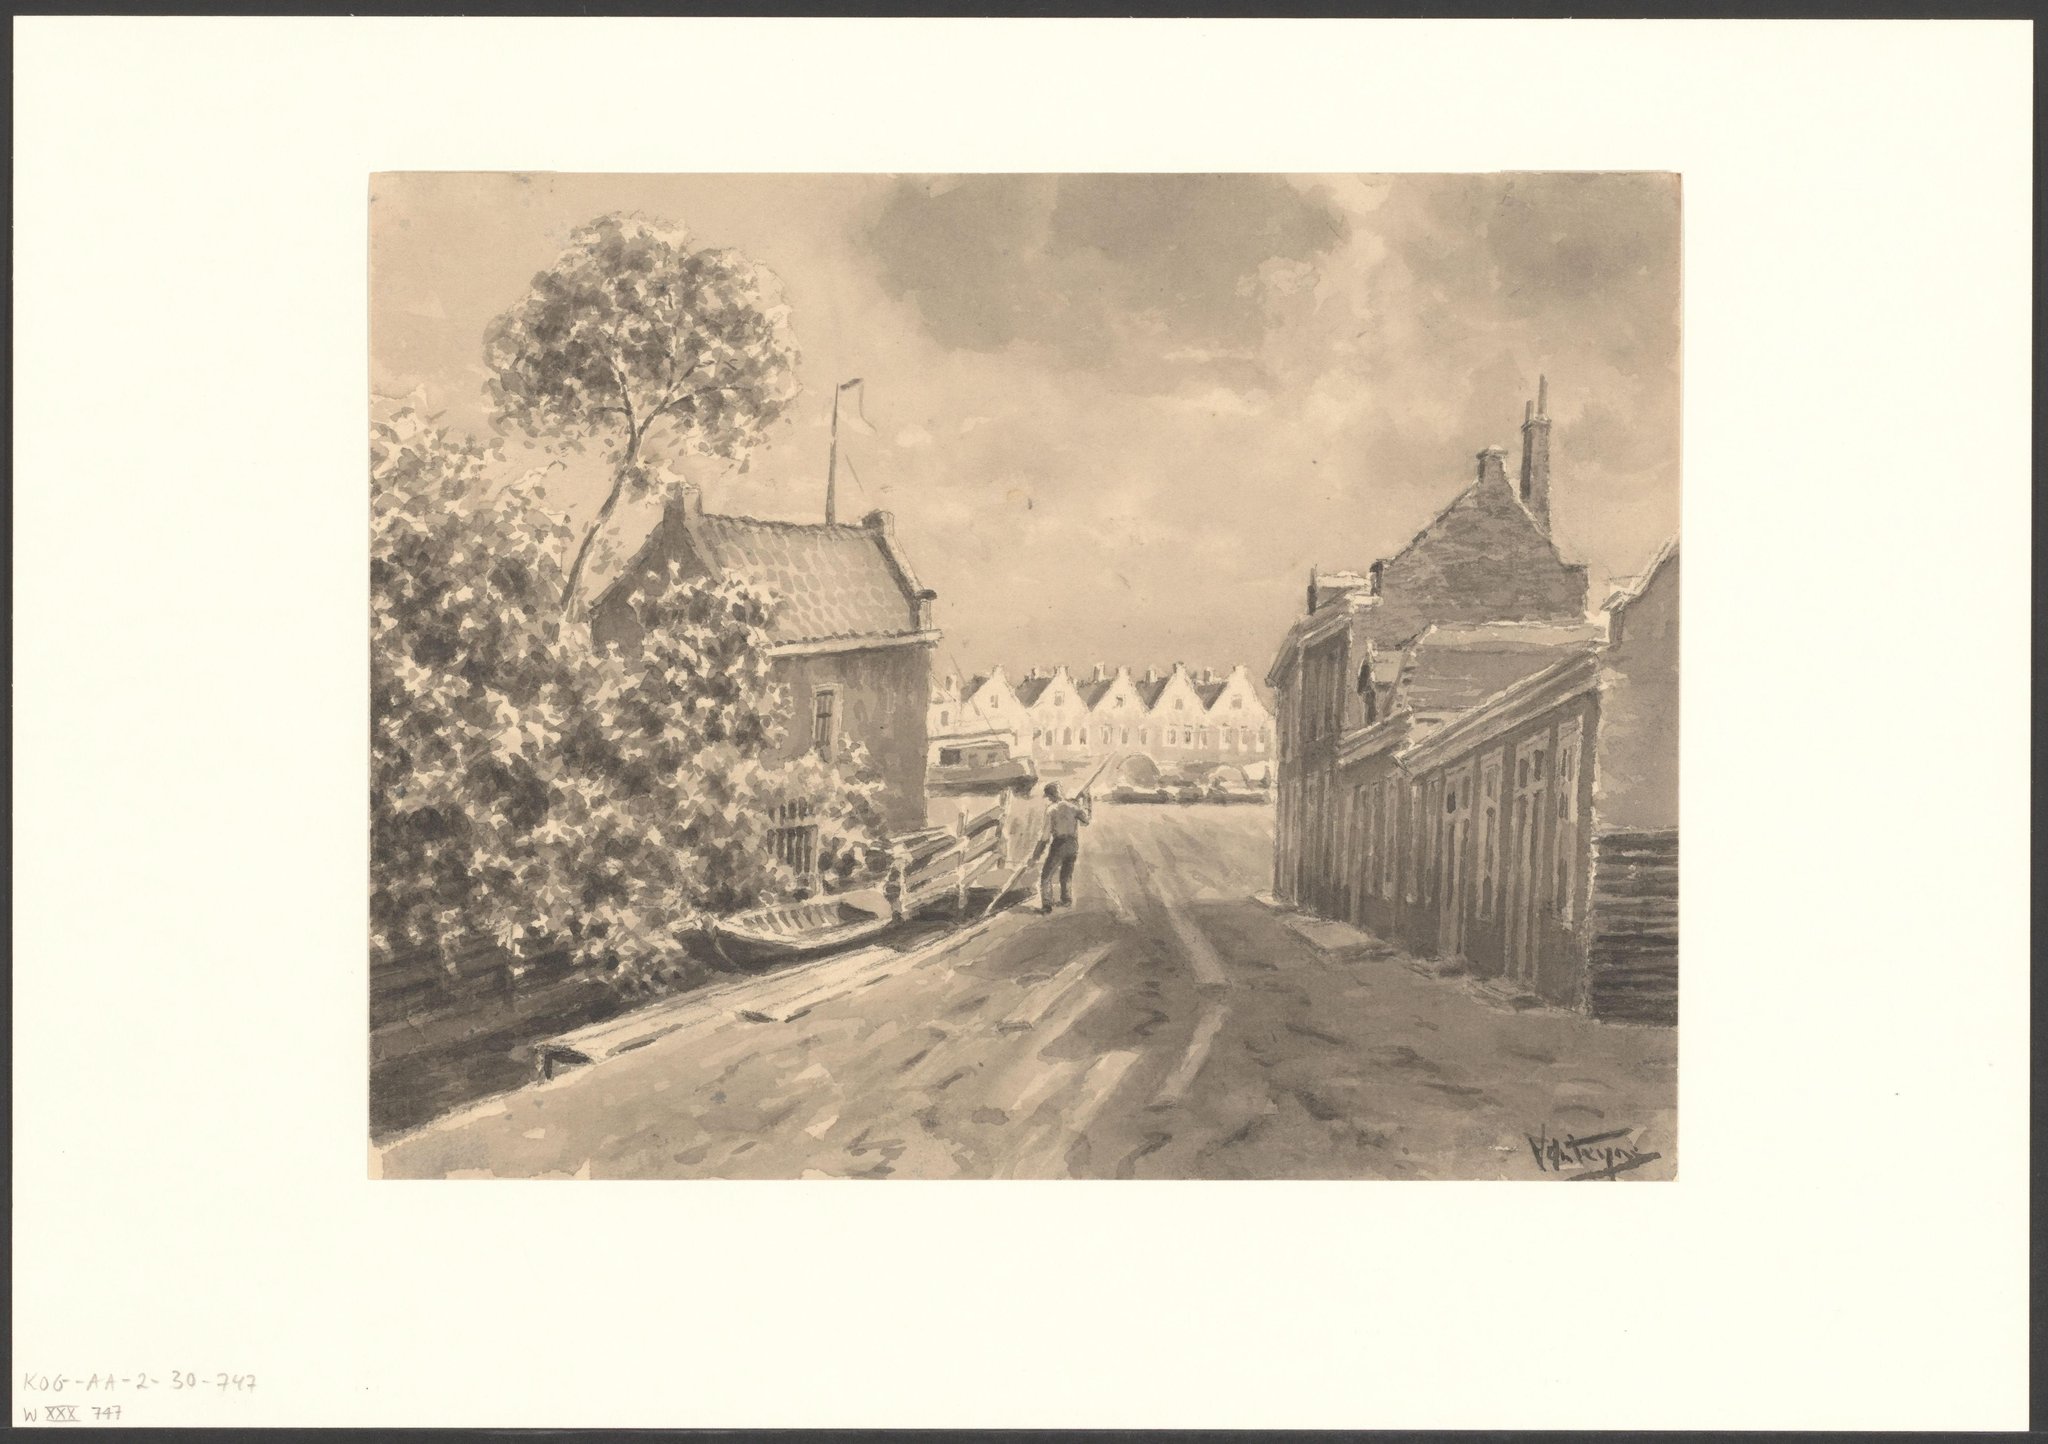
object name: drawing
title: Gezicht op een pad aan de Baarsjesweg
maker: anthonie van teijn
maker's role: draughtsman, painter, print maker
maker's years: 1863-1943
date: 1907-1927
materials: ink, paper, pencil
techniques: brush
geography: amsterdam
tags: city-view in general; 'veduta', road, path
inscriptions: signature: ‘VanTeyne’, inscription: ‘Pad aan de (...) Juli 1927. / vEck’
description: Tekening binnen de Atlas Van Eck ingedeeld op wijknummer 30.